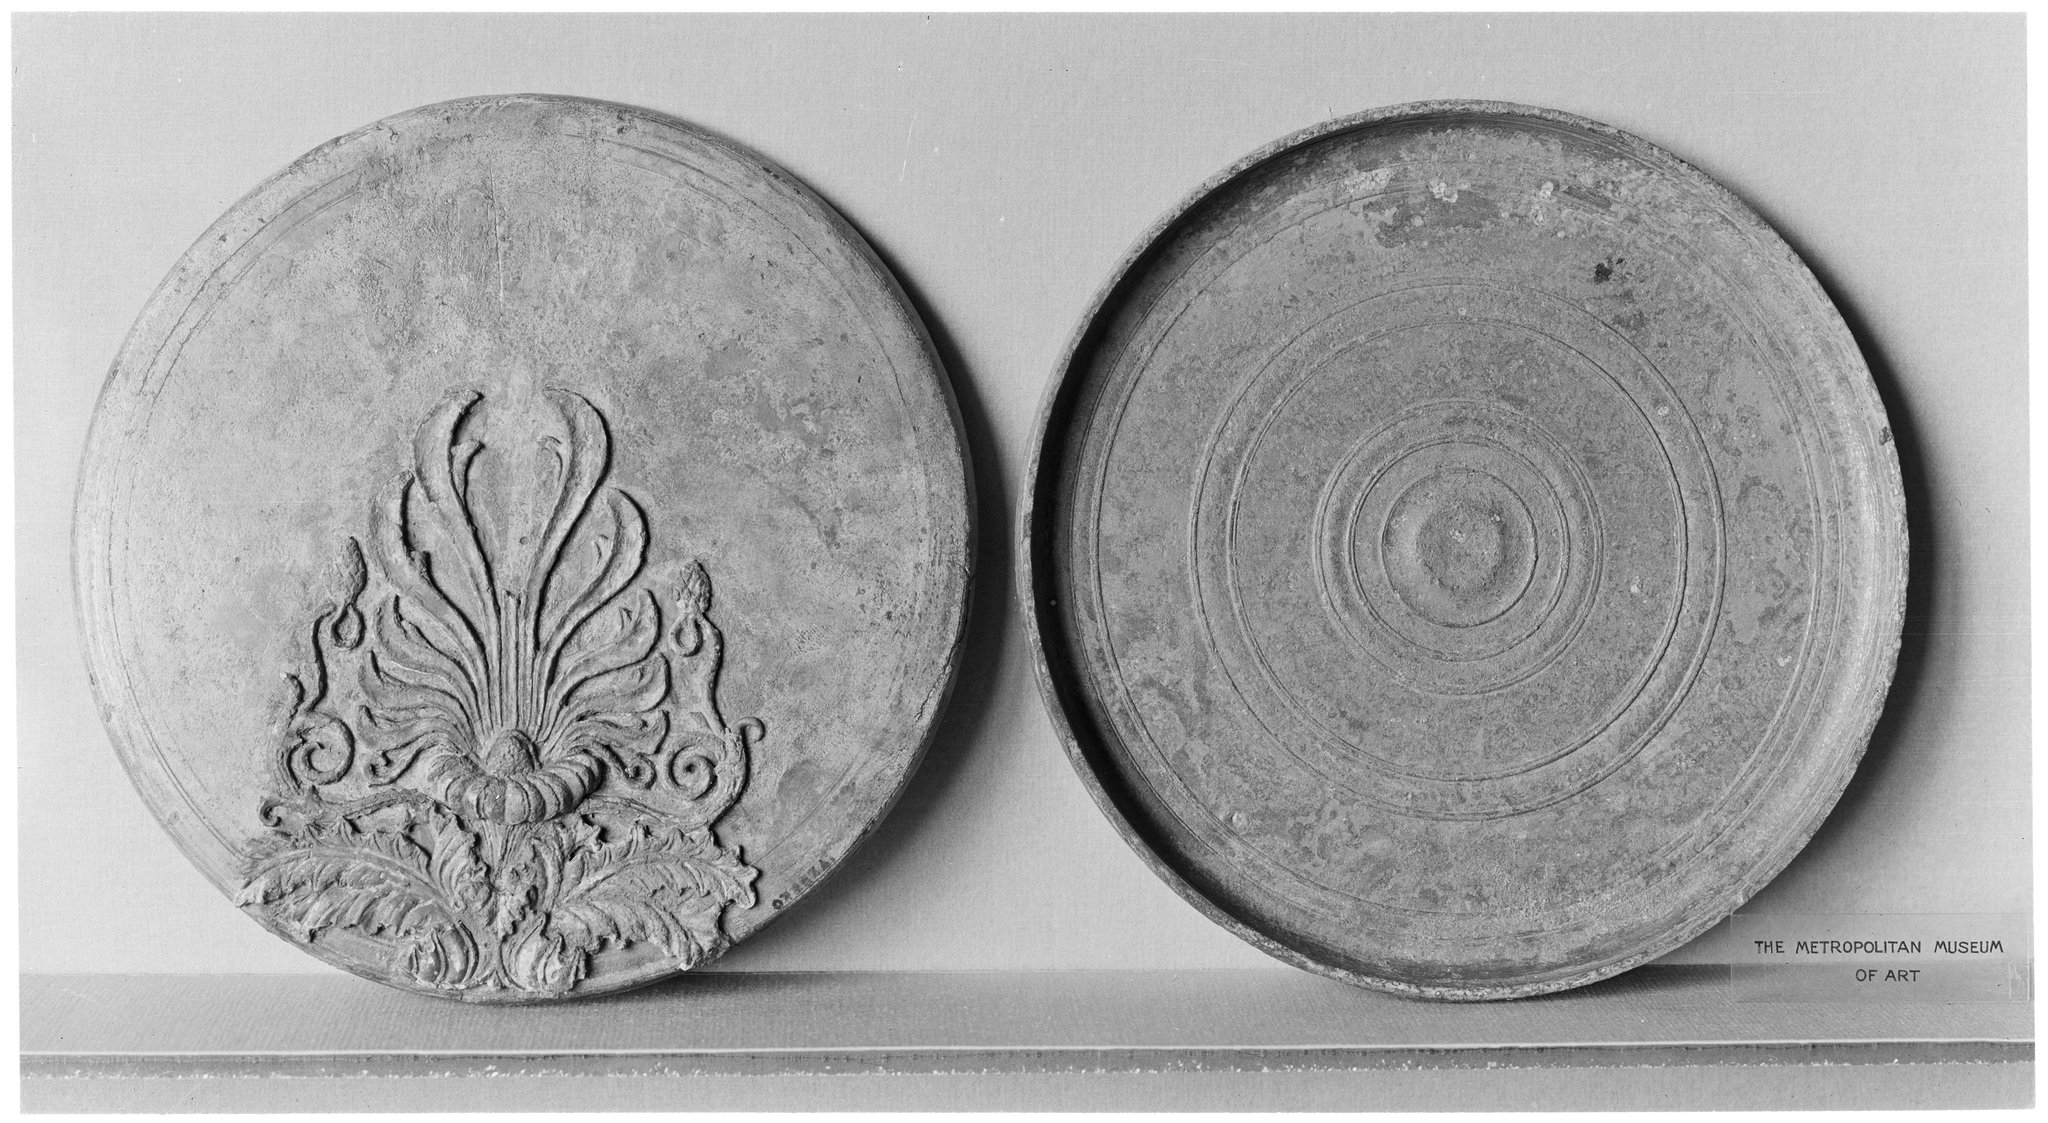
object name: mirror with cover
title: Bronze box mirror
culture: greek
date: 375-351 BCE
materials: bronze